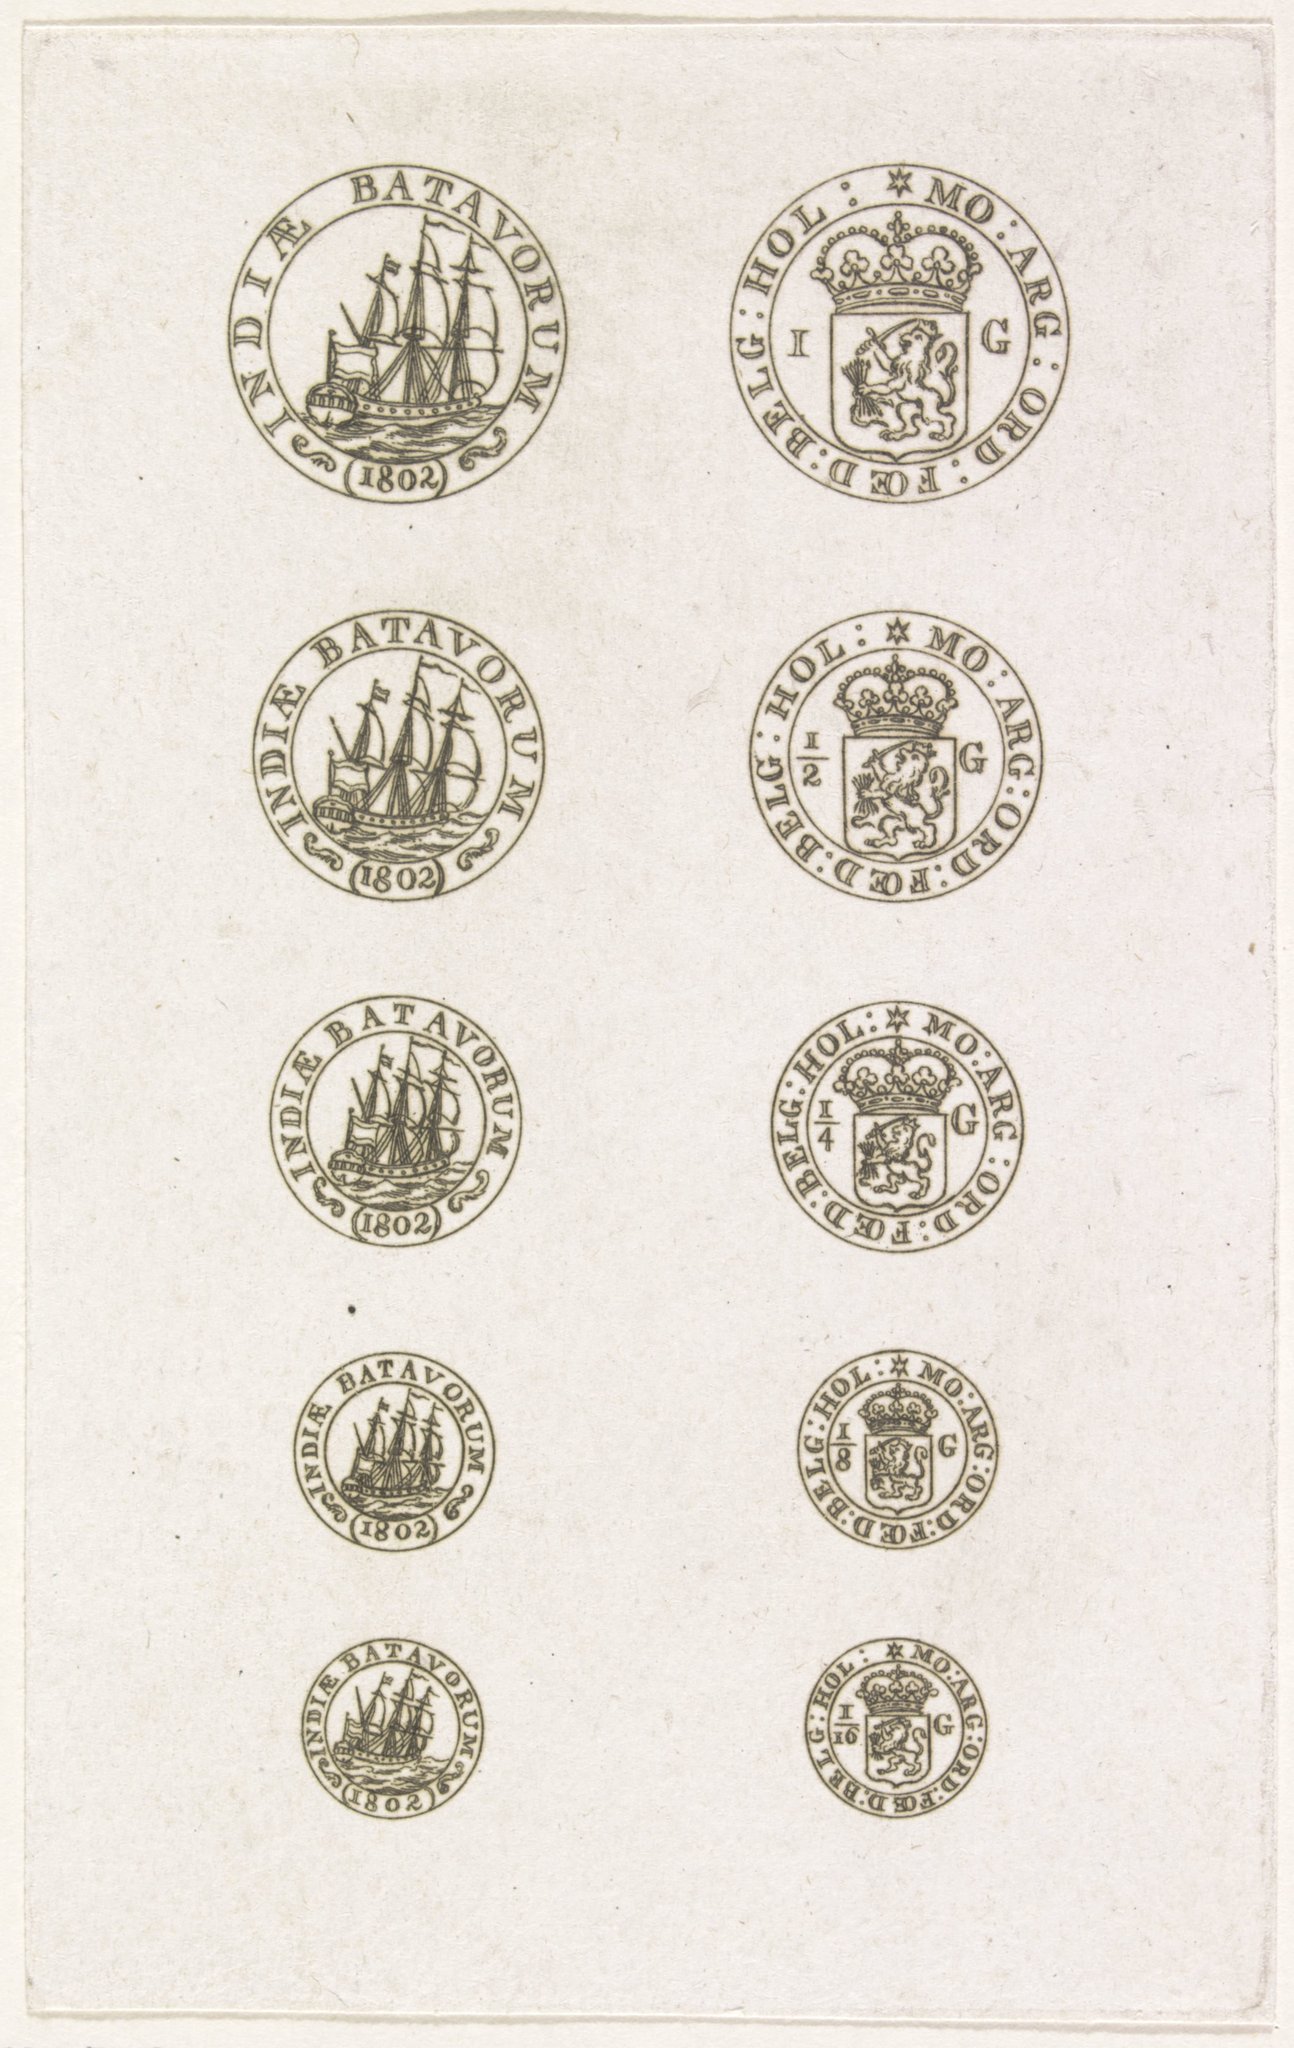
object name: print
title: Munten voor Bataafs Indië, 1802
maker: Anonymous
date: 1802-1803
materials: paper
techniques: etching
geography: netherlands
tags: coin, dutch east indies, the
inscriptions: collector's mark: Lugt 2228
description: Vijf nieuwe munten geslagen in Enkhuizen voor voor Bataafs Indië. De munten dragen het opschrift 'Indiae Batavorum' en het jaar 1802.